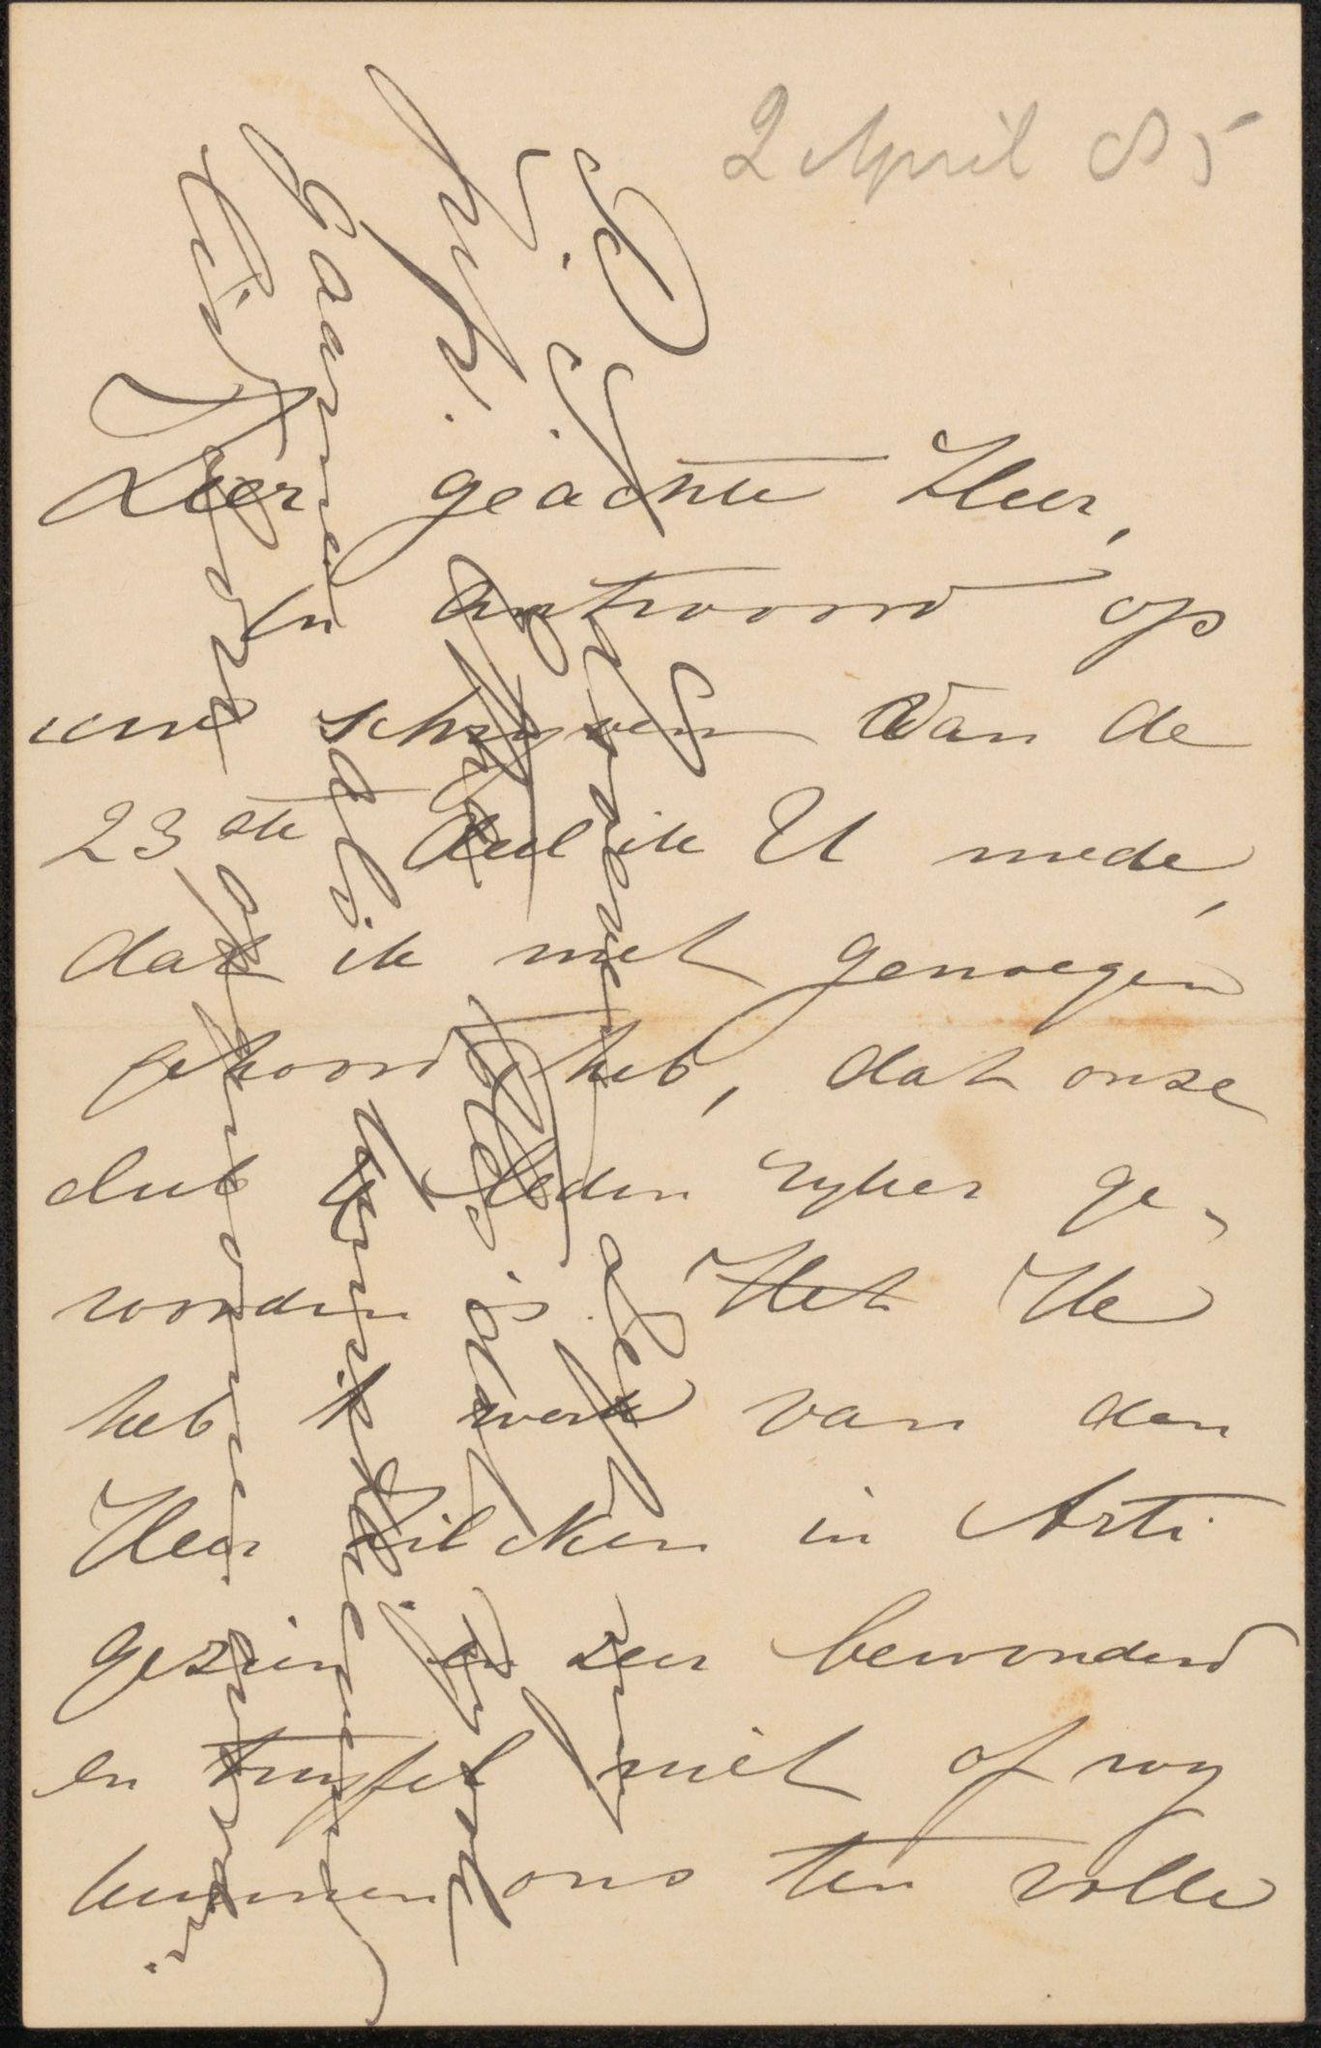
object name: letter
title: Brief aan Jan Veth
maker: wally moes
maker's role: draughtsman, print maker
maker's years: 1856-1918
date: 1874-1918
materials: ink, paper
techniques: pen, writing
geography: amsterdam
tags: dordrecht, print maker, designer, jan veth, marie wandscheer, etha fles, the hague, painter, draughtsman, philip zilcken, exhibition ~ art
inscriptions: collector's mark: ‘RPK’